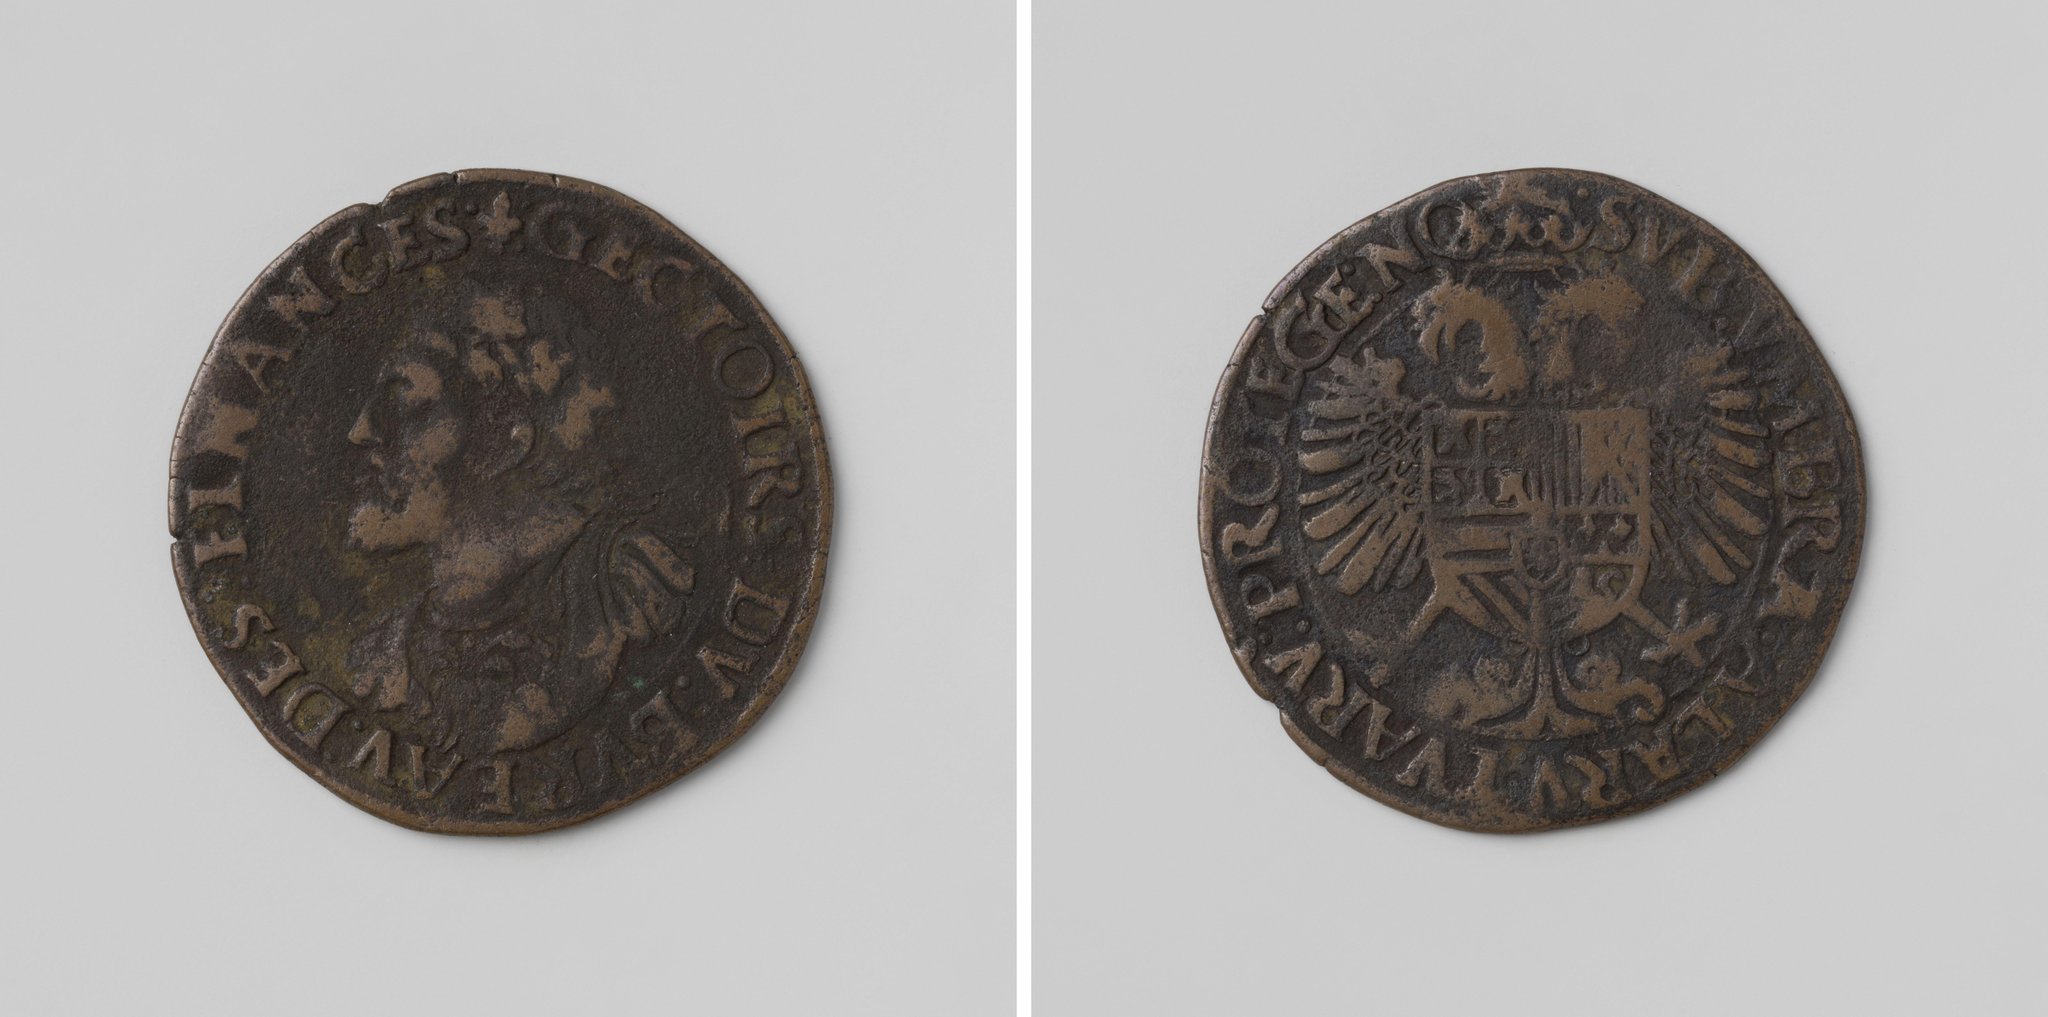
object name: jeton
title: Aansporing van Karel V, Duits keizer, om de rust te bewaren, rekenpenning van raad van Financiën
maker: Anonymous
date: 1546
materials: copper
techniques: striking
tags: ghent, charles v (holy roman emperor and king of spain)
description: Koperen penning. Voorzijde: borststuk man met lauwerkrans binnen omschrift. Keerzijde: tweekoppige adelaar onder kroon met wapenschild binnen omschrift